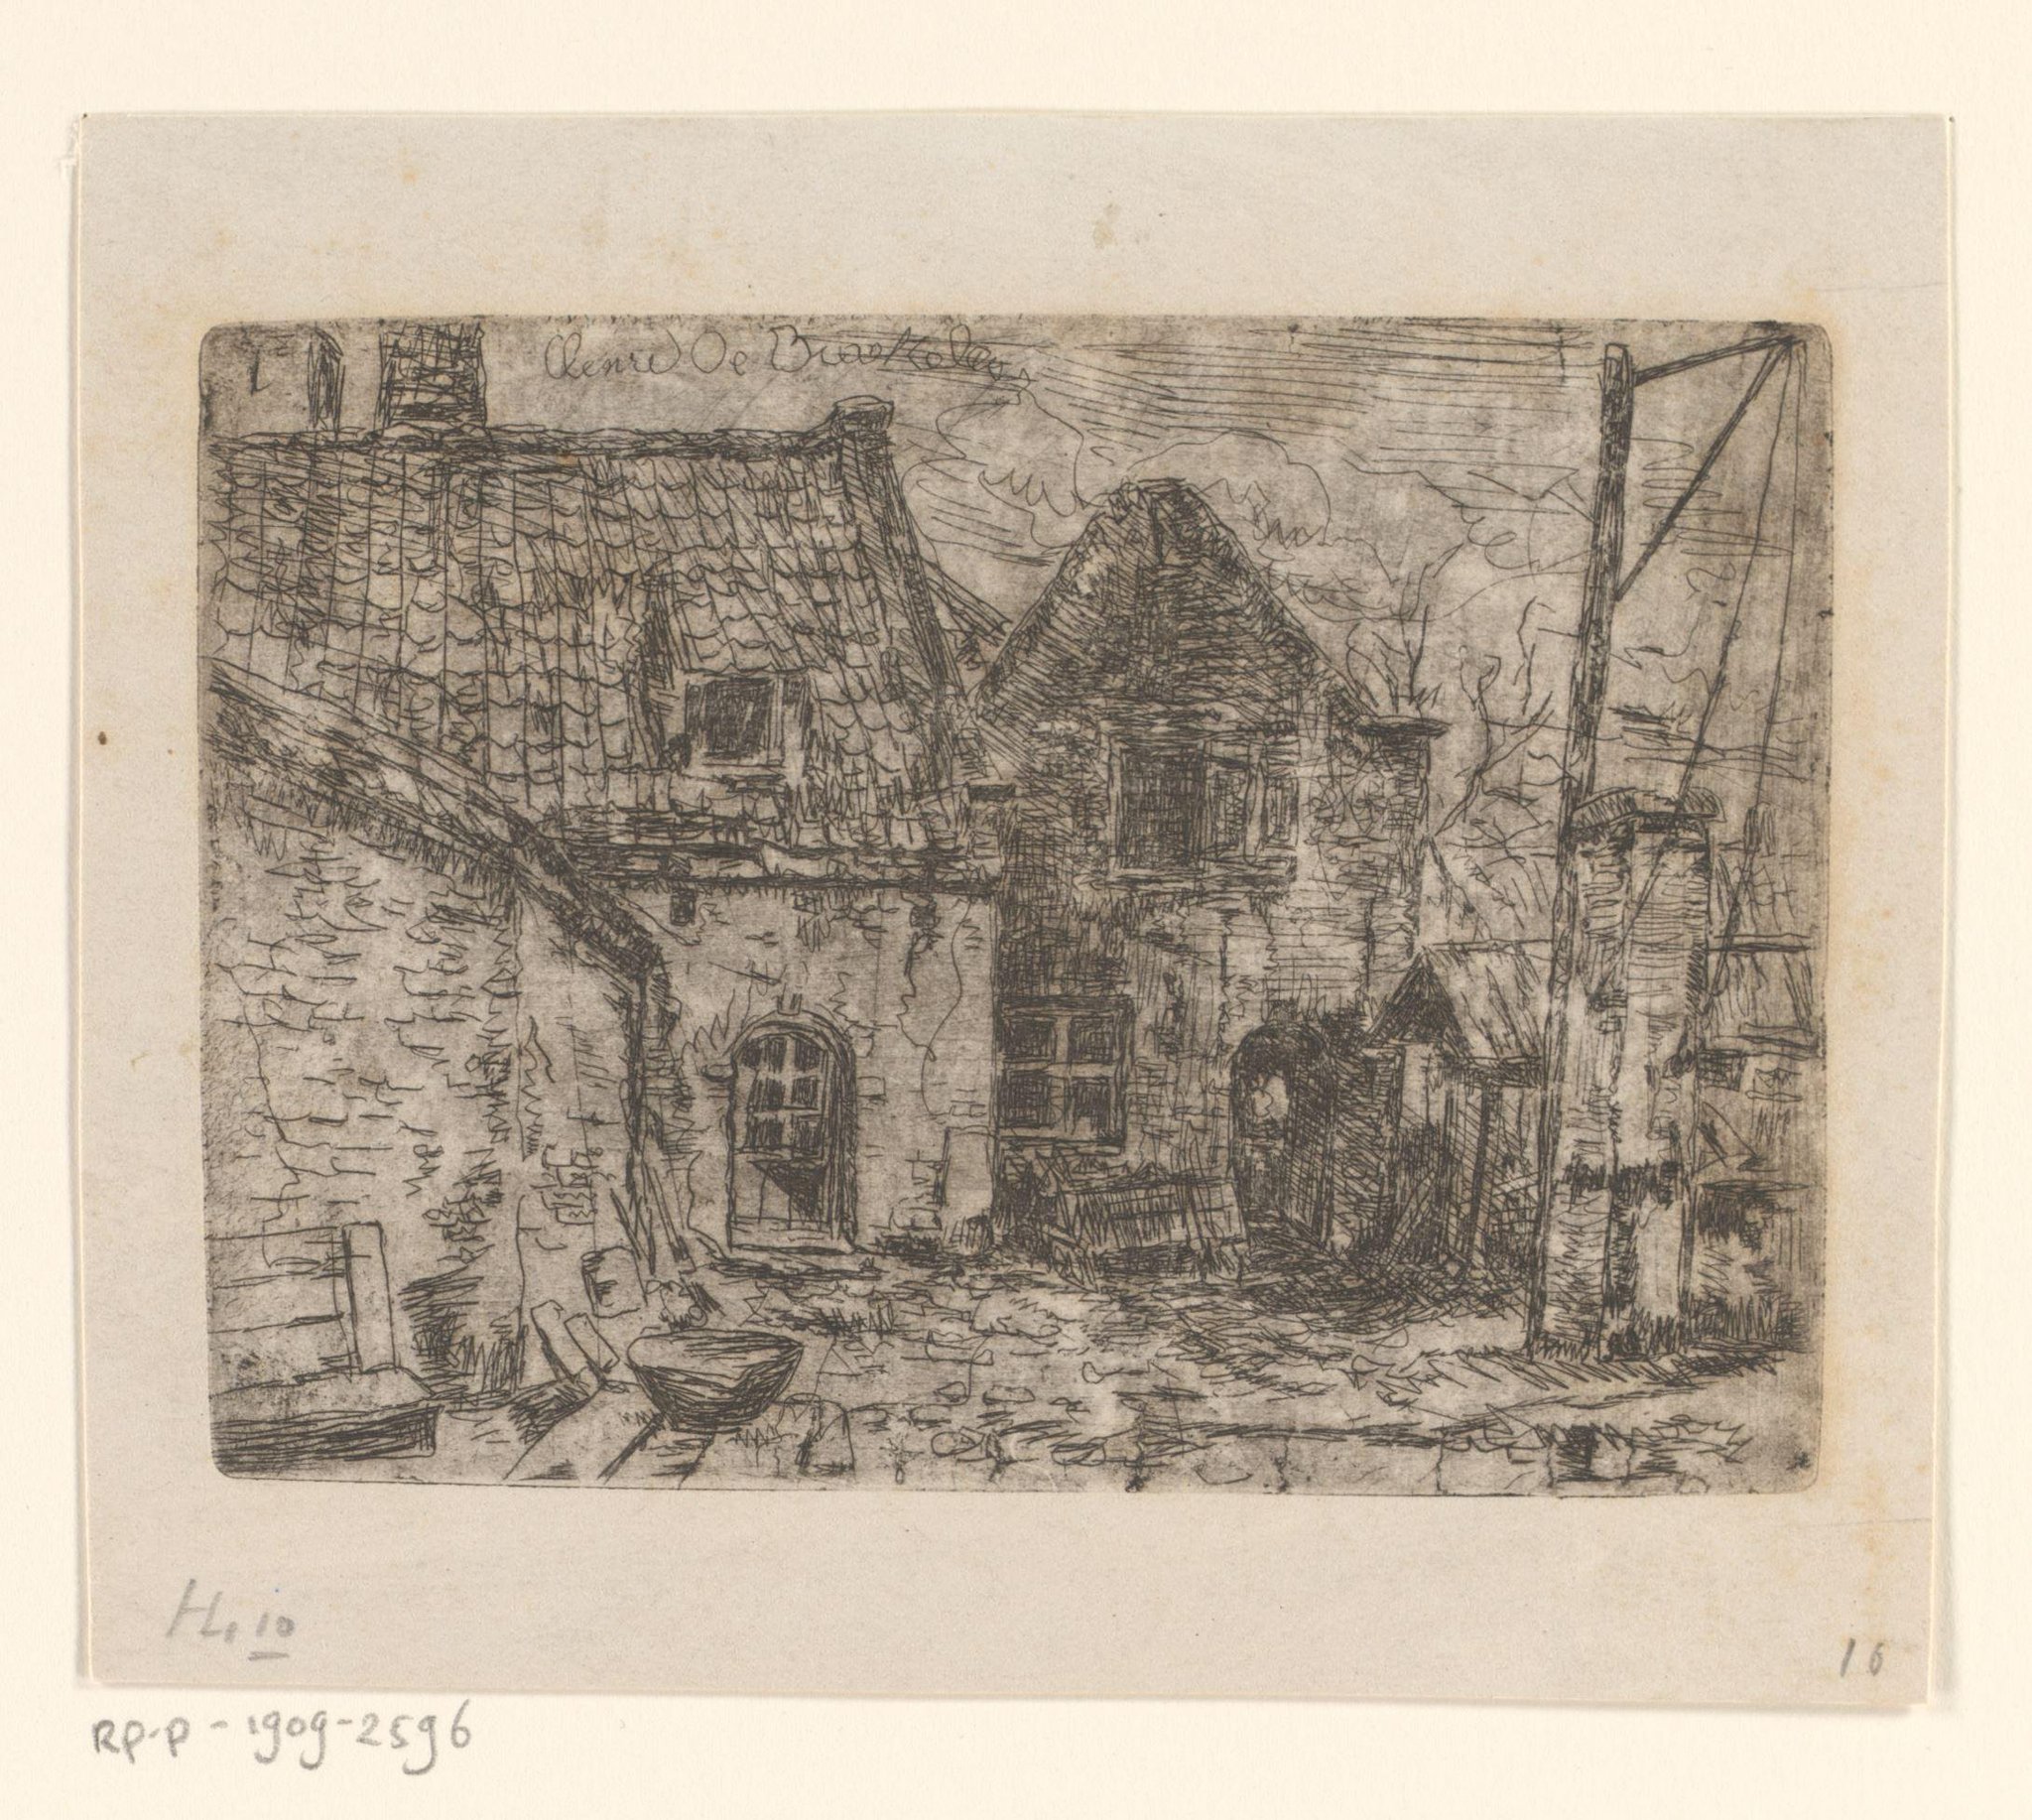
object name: print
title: Erf met een waterkruik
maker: henri de braekeleer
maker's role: draughtsman, print maker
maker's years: 1840-1888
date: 1850-1879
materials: paper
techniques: etching, intaglio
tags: courtyard, container of ceramics: jar, jug, pot, vase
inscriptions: collector's mark: Lugt 1485, collector's mark: Lugt 2228